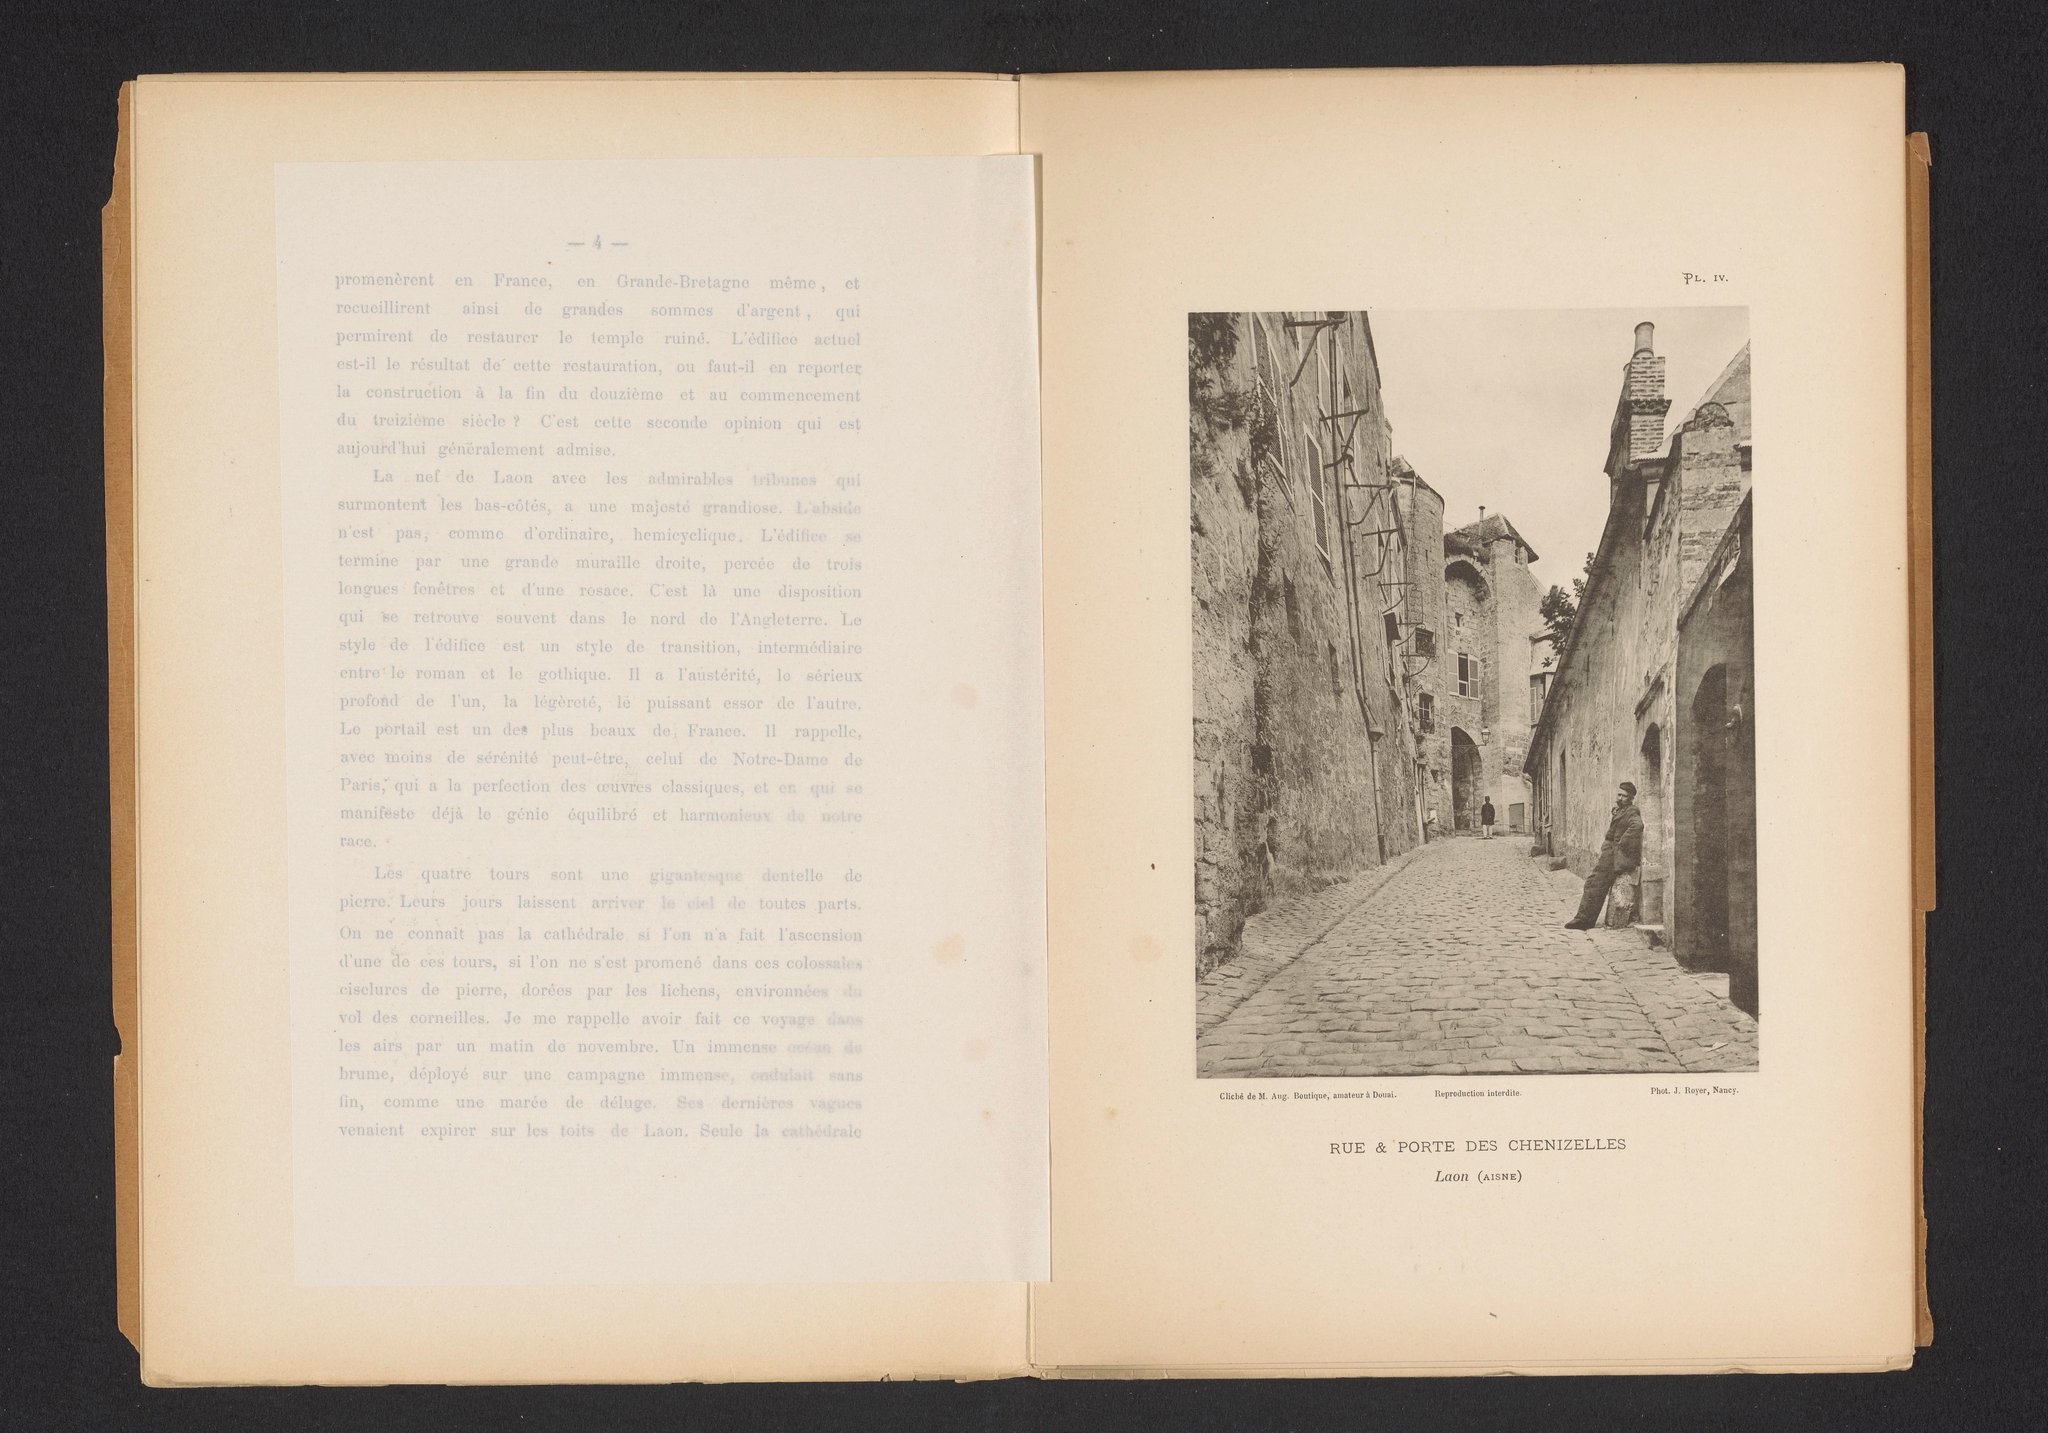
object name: photomechanical print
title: Rue & Porte des Chenizelles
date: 1891-1896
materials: paper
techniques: photograph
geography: douai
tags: gate, entrance, street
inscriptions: inscription: ‘Reproduction interdite.’, number: ‘Pl. IV.’